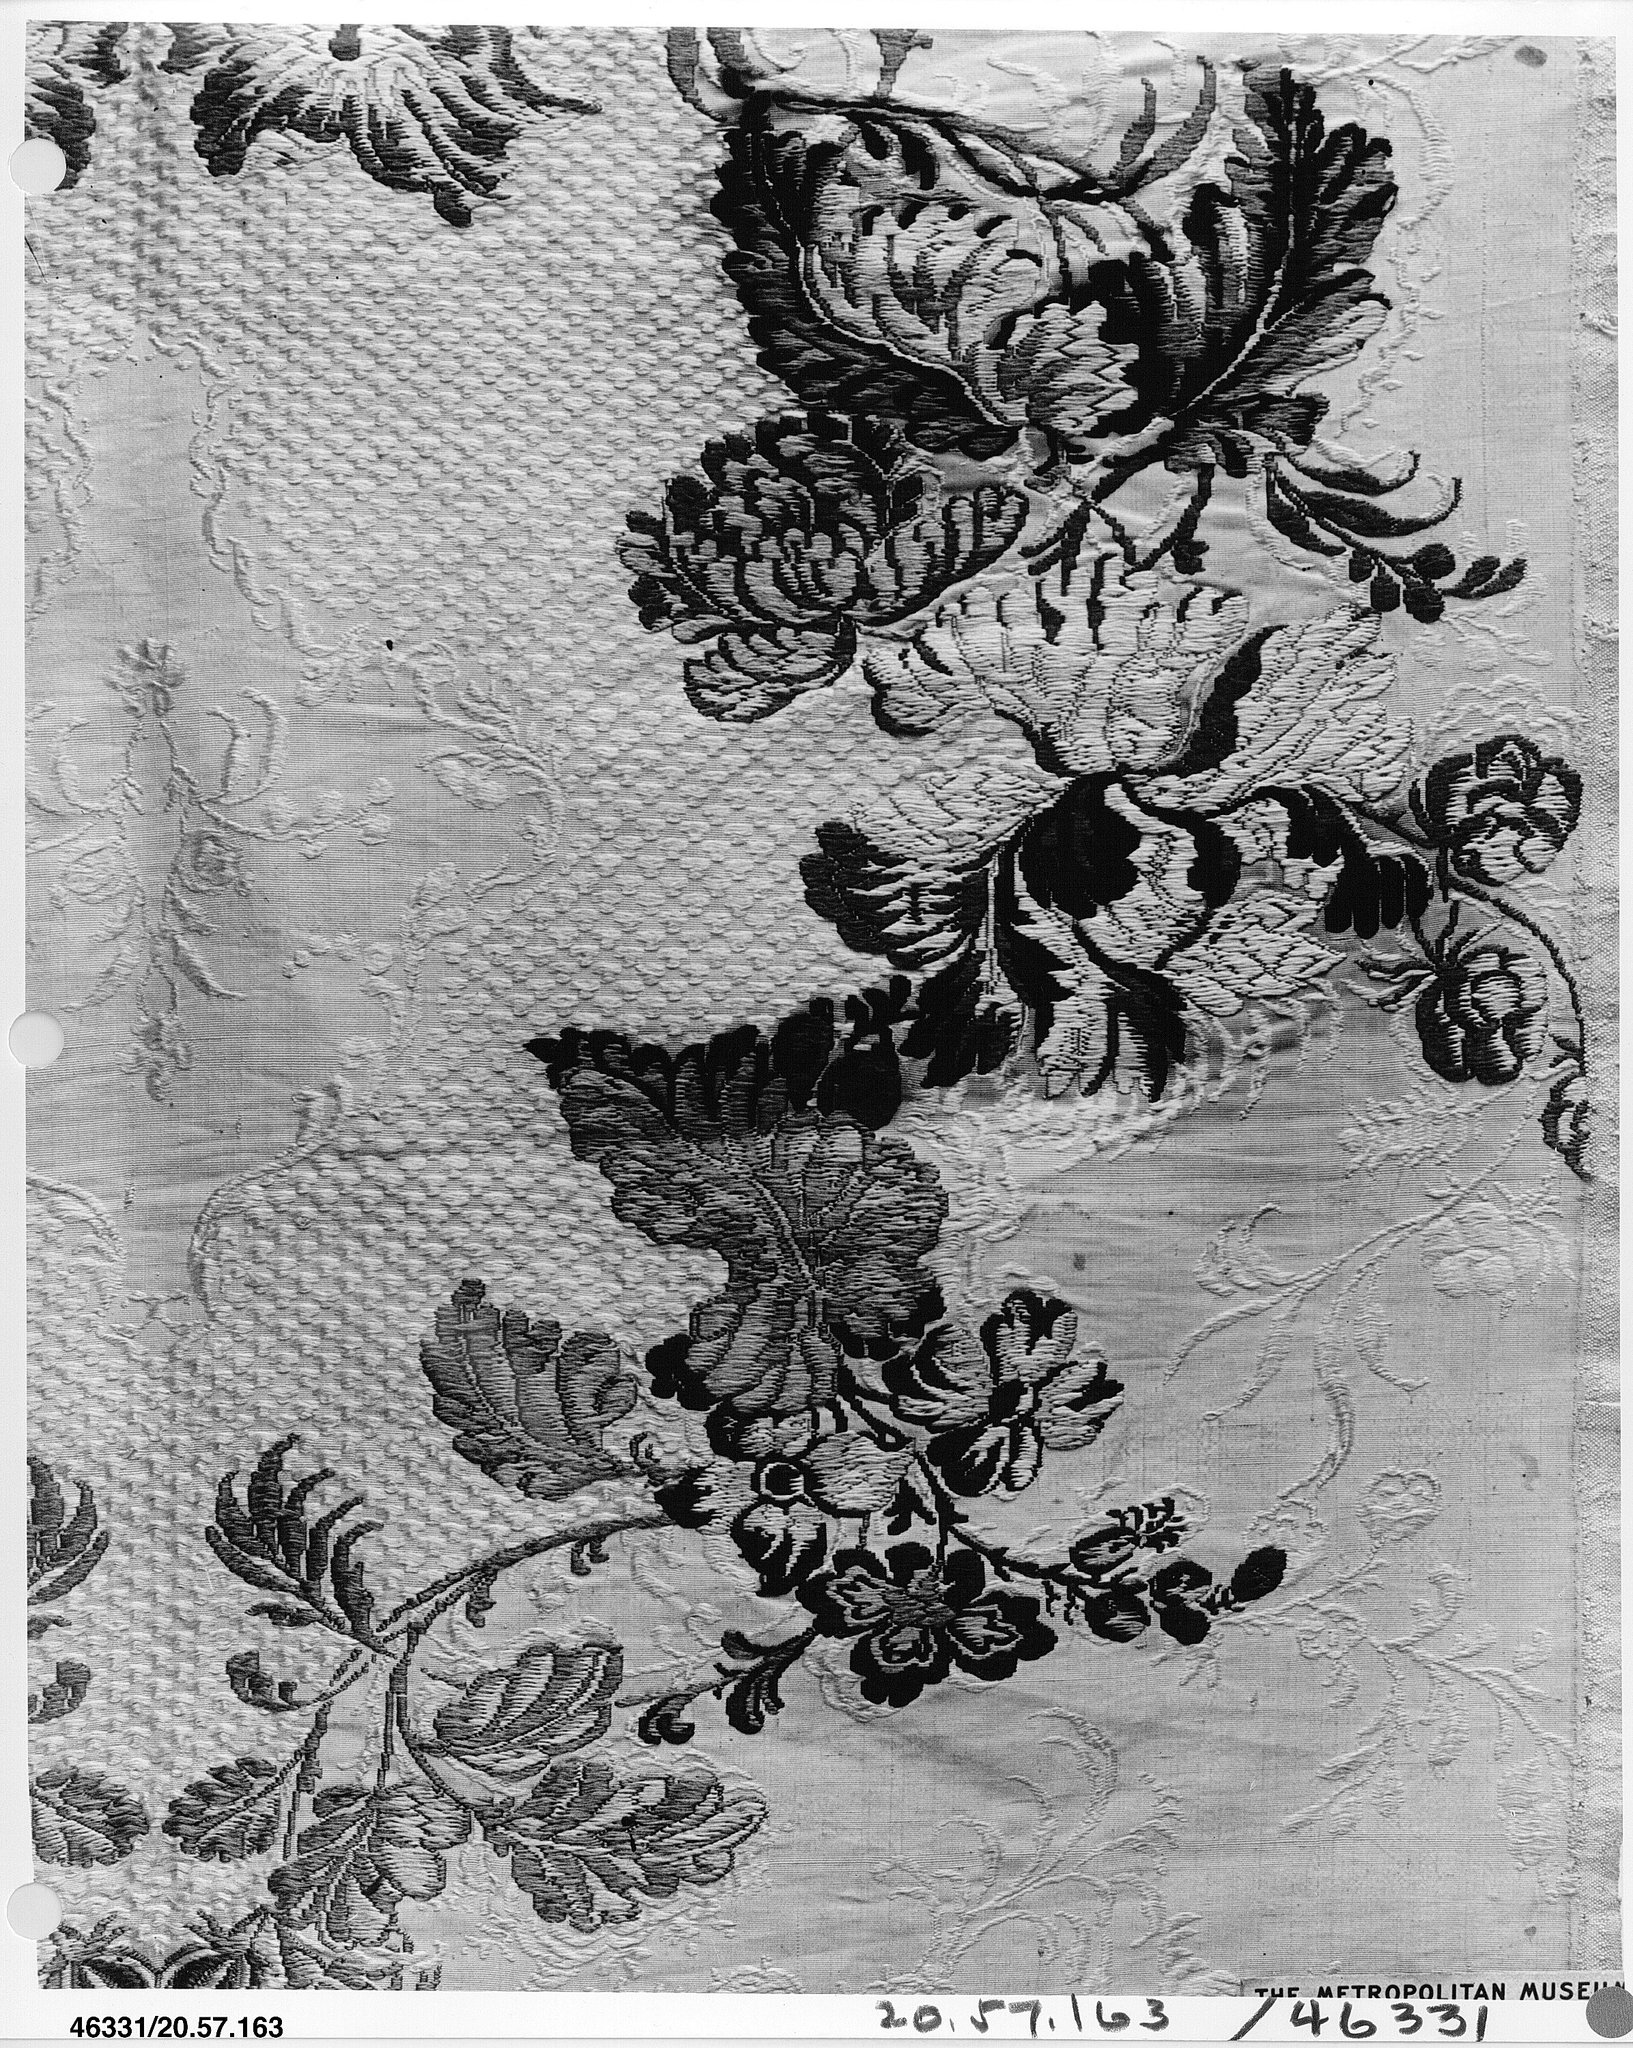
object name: piece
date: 1730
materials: silk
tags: flowers,leaves